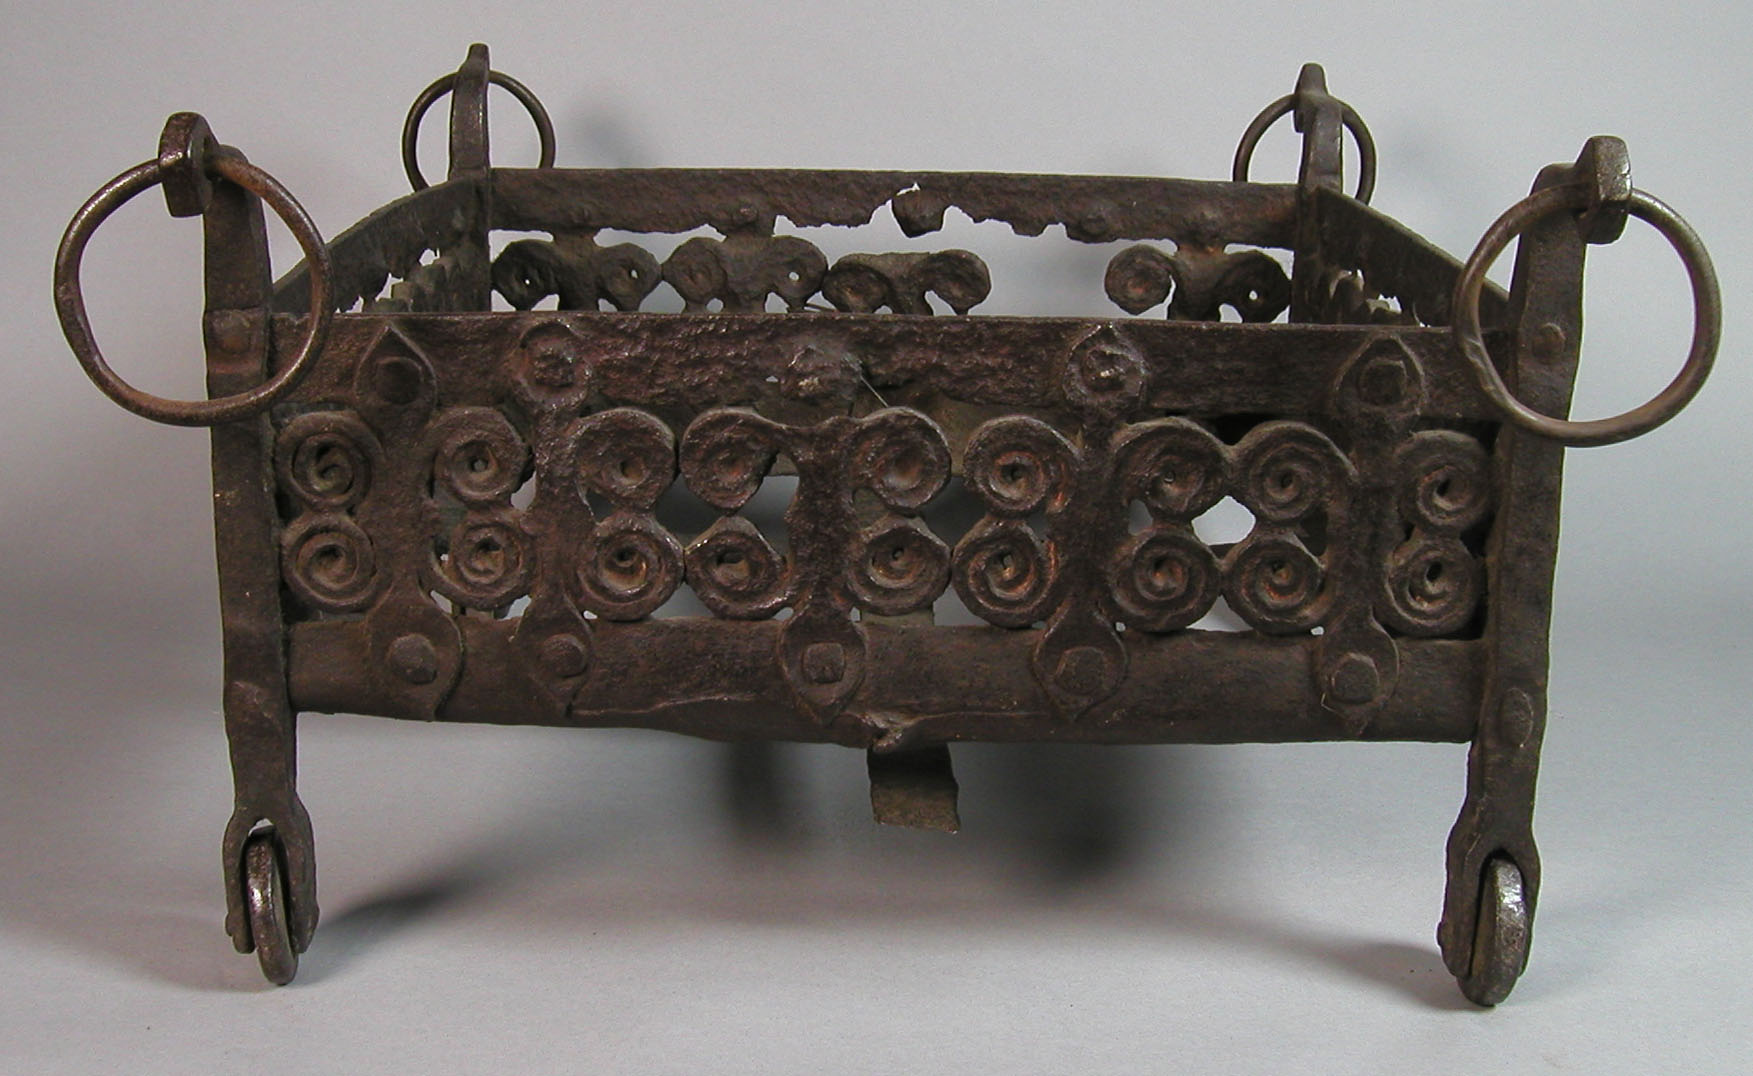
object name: brazier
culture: spanish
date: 1201-1300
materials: iron